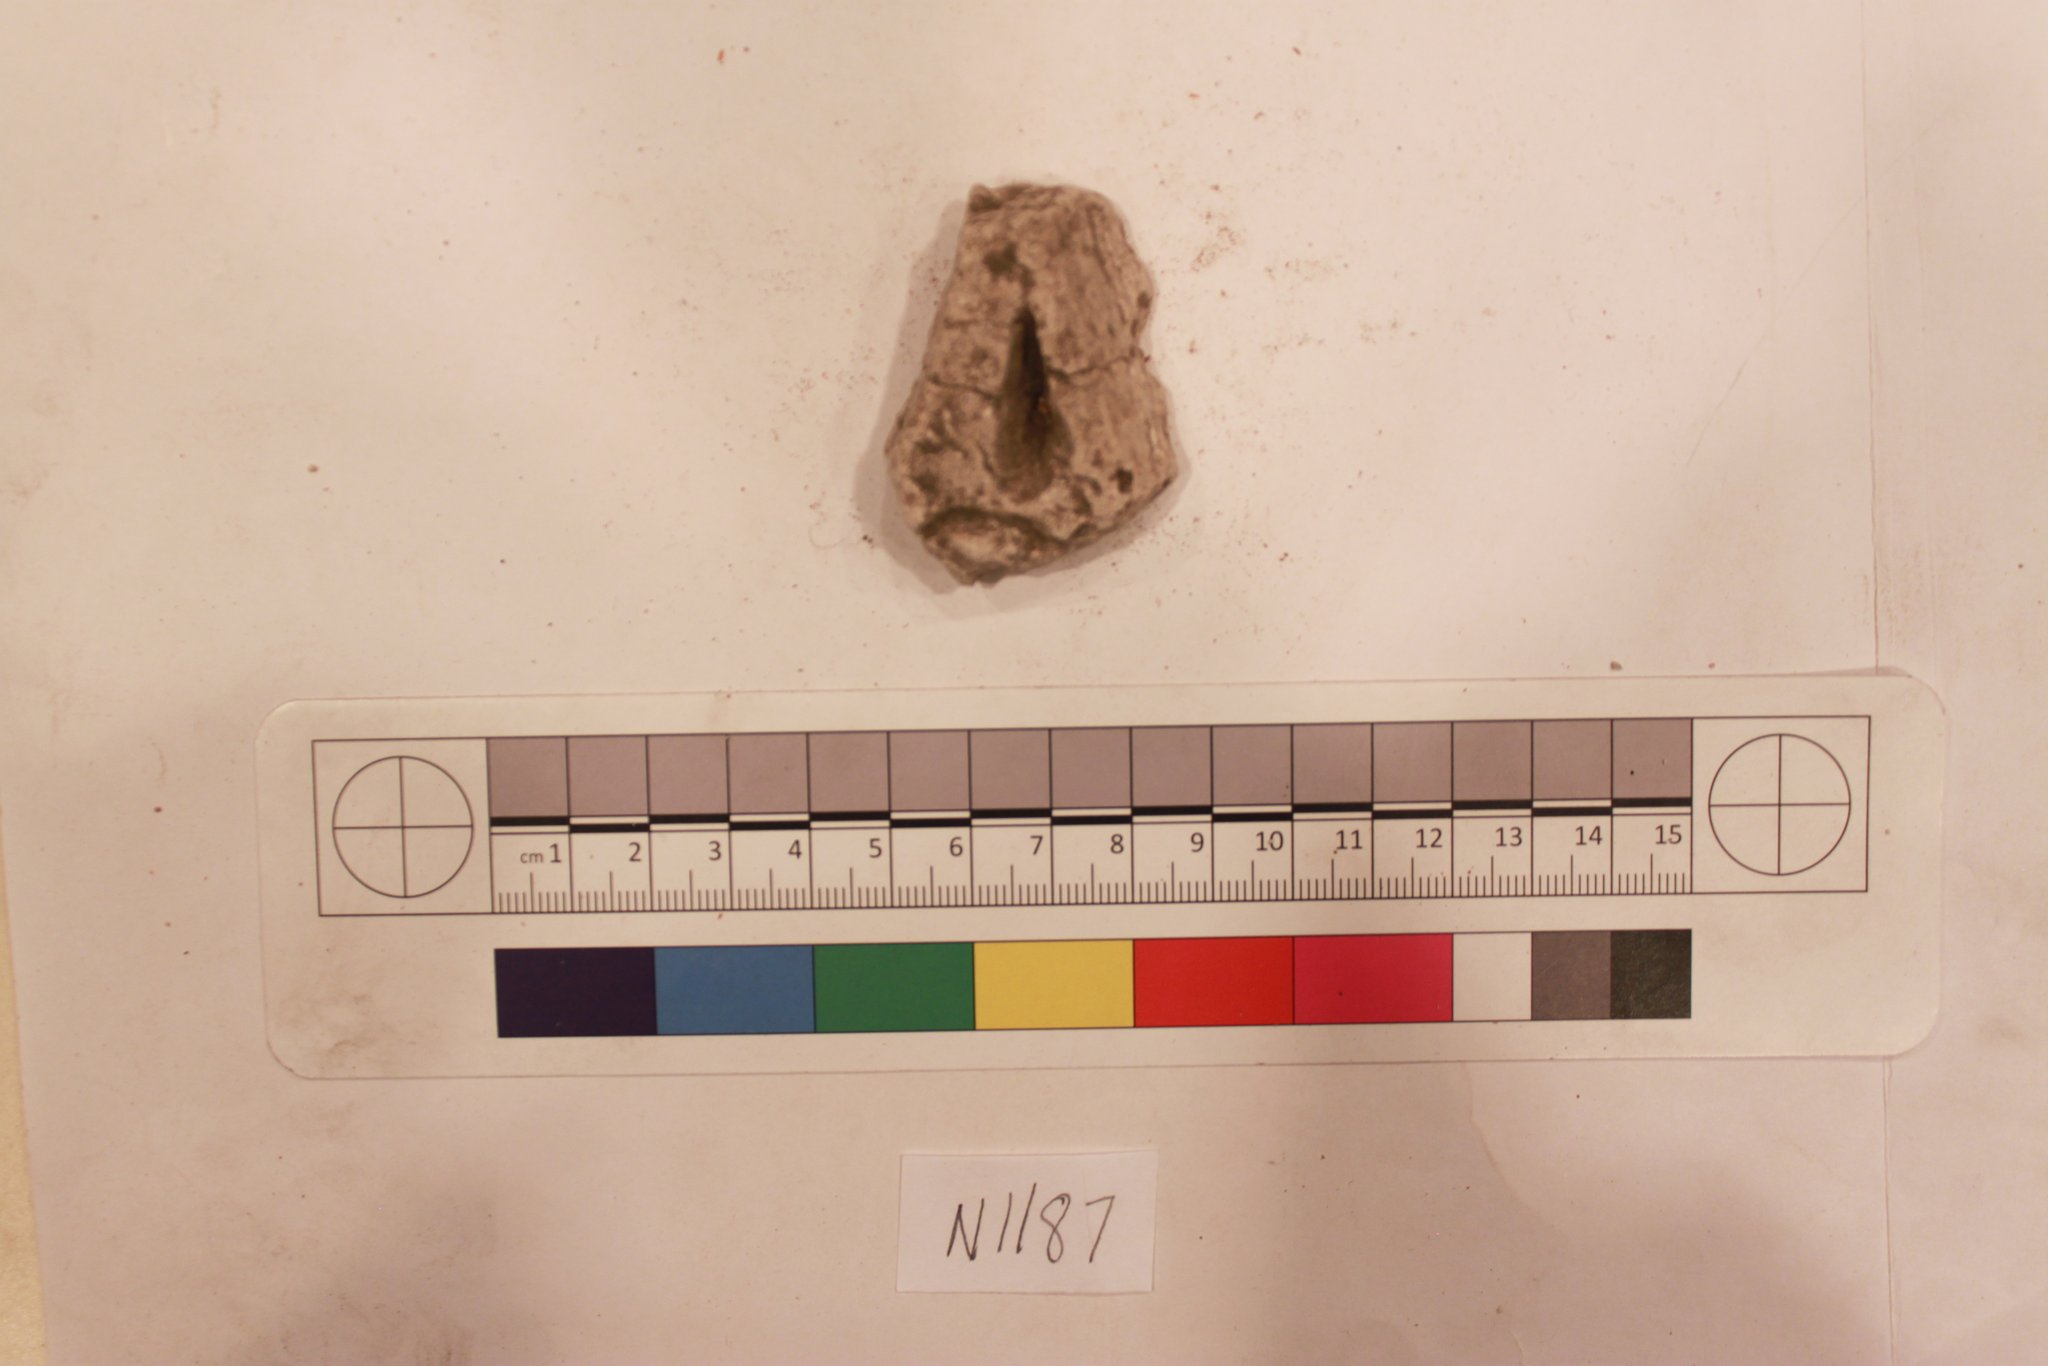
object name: fragment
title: Stucco Fragment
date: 701-1200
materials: plaster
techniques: carving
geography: iran